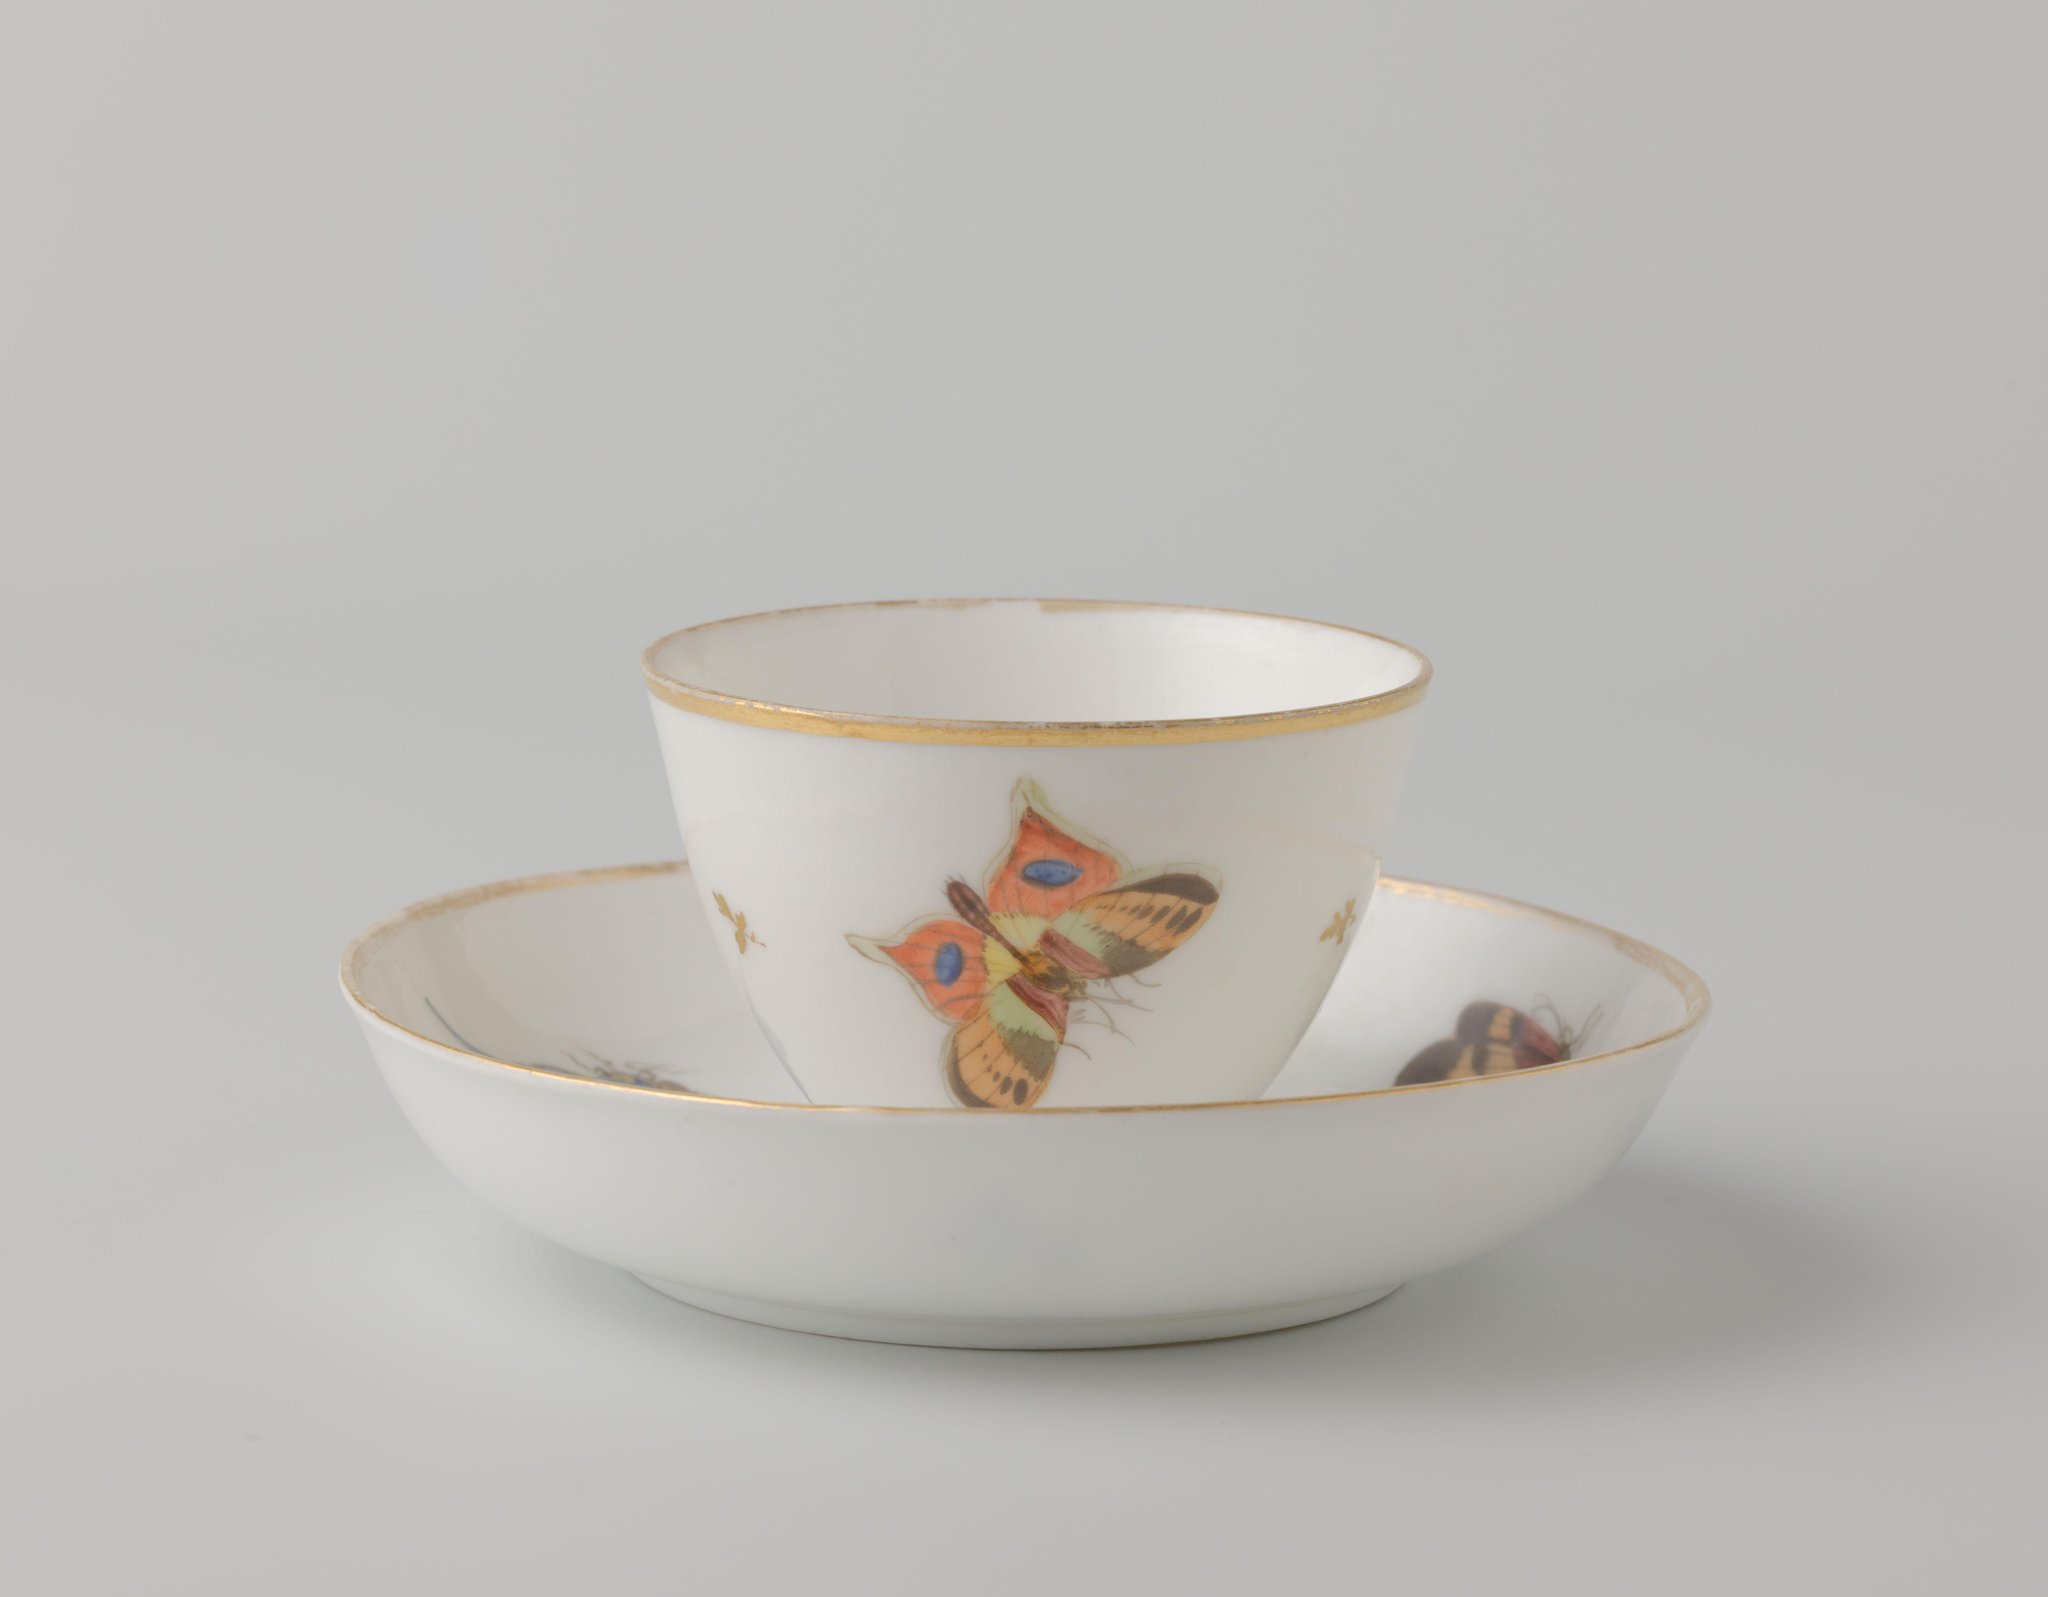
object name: cup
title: Kop beschilderd met vlinders en libellen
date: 1784-1809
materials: porcelain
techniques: painted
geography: ouder-amstel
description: Kop zonder oor en veelkleurig beschilderd met vlinders en libellen. Gemerkt: Amstel.